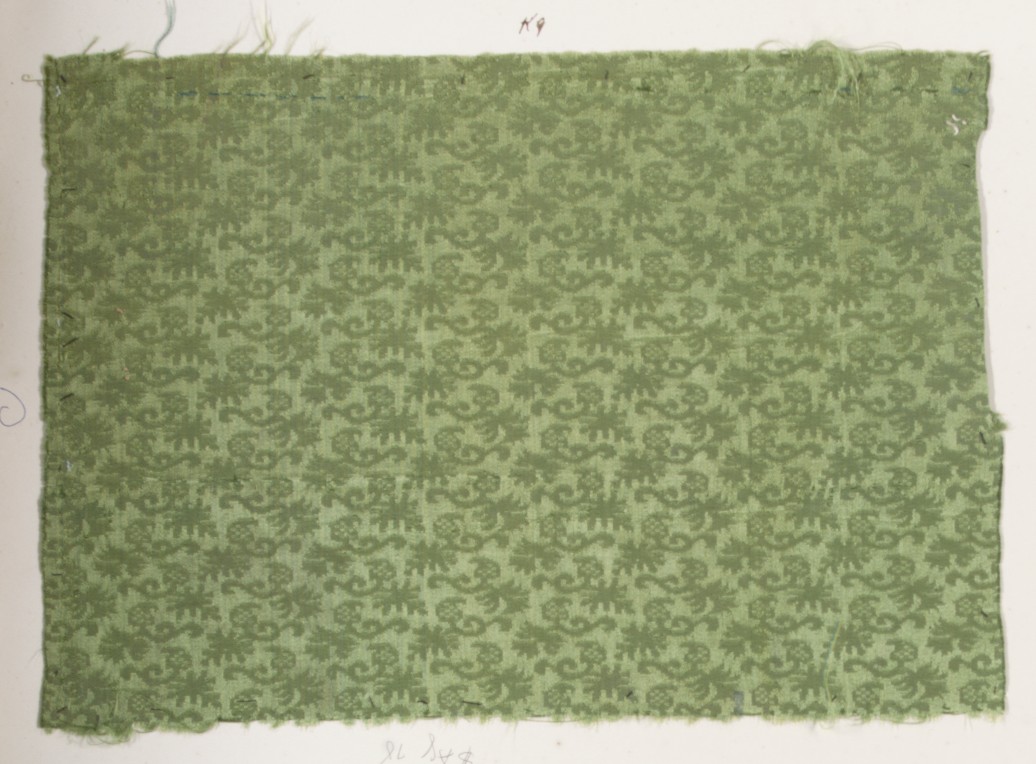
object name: fragment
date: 1501-1600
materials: silk